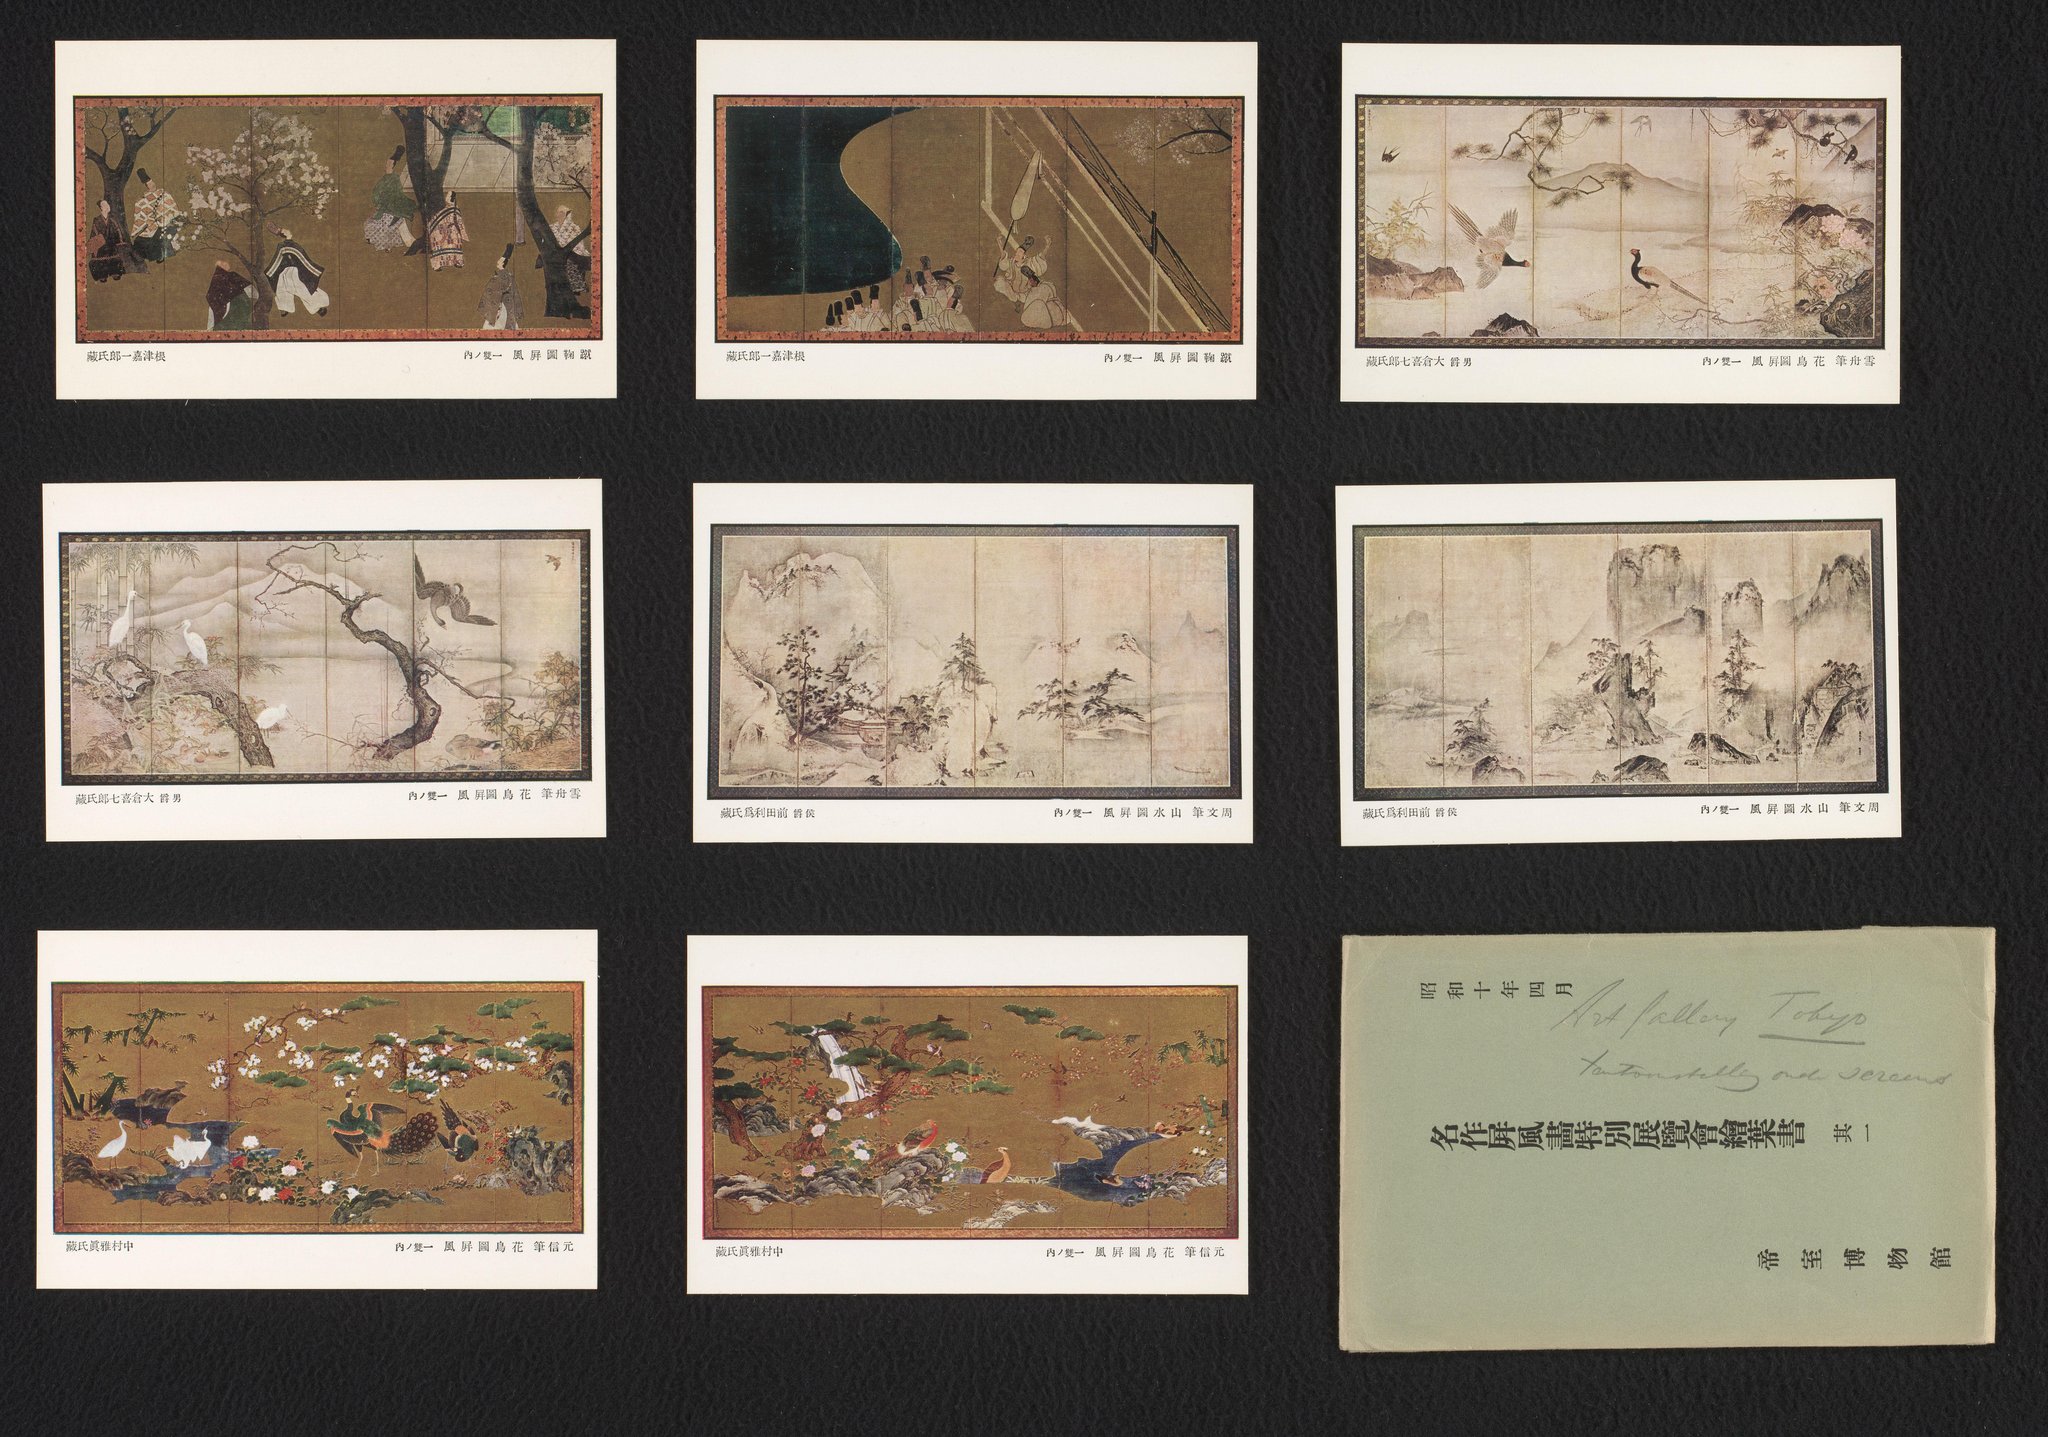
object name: ansichtkaart, prentbriefkaart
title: Prentbriefkaarten met ontwerpen voor kamerschermen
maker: Anonymous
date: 1925-1940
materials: paper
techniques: lithograph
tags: screen, folding screen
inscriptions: inscription: ‘Art Gallery Tokyo/ tentoonstelling oude screens’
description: Acht prentbriefkaarten met ontwerpen voor kamerschermen in een envelop.